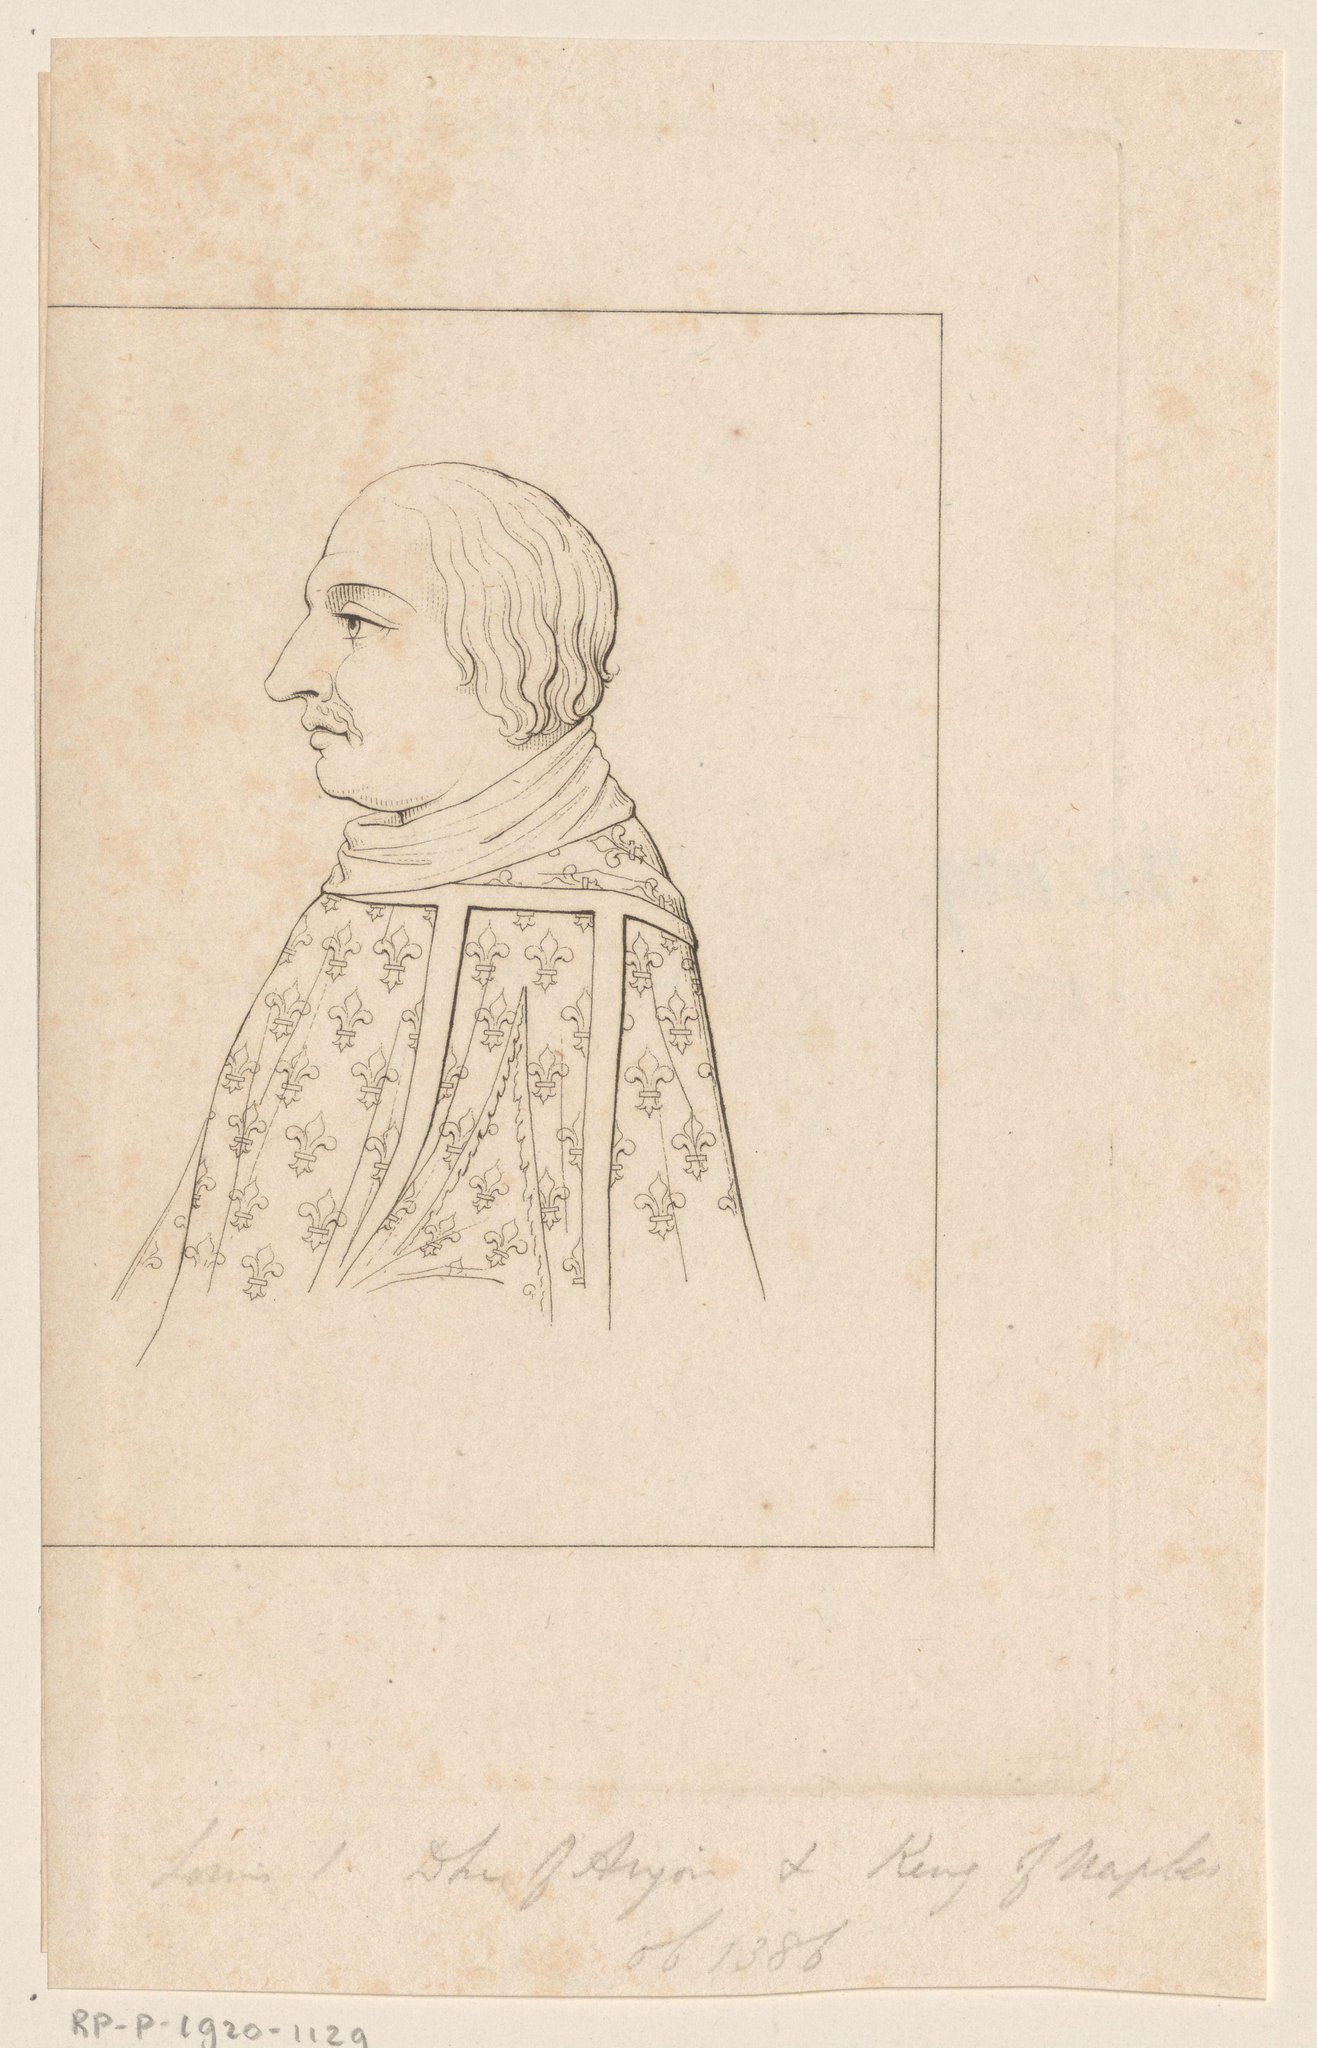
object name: print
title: Portret van Lodewijk I, hertog van Anjou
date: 1809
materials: paper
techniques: etching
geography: wales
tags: historical persons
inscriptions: collector's mark: Lugt 2228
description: Latere staat, met opschrift, verschenen in: The Chronicles of Enguerrand de Monstrelet (...). Hafod: James Henderson, 1809.